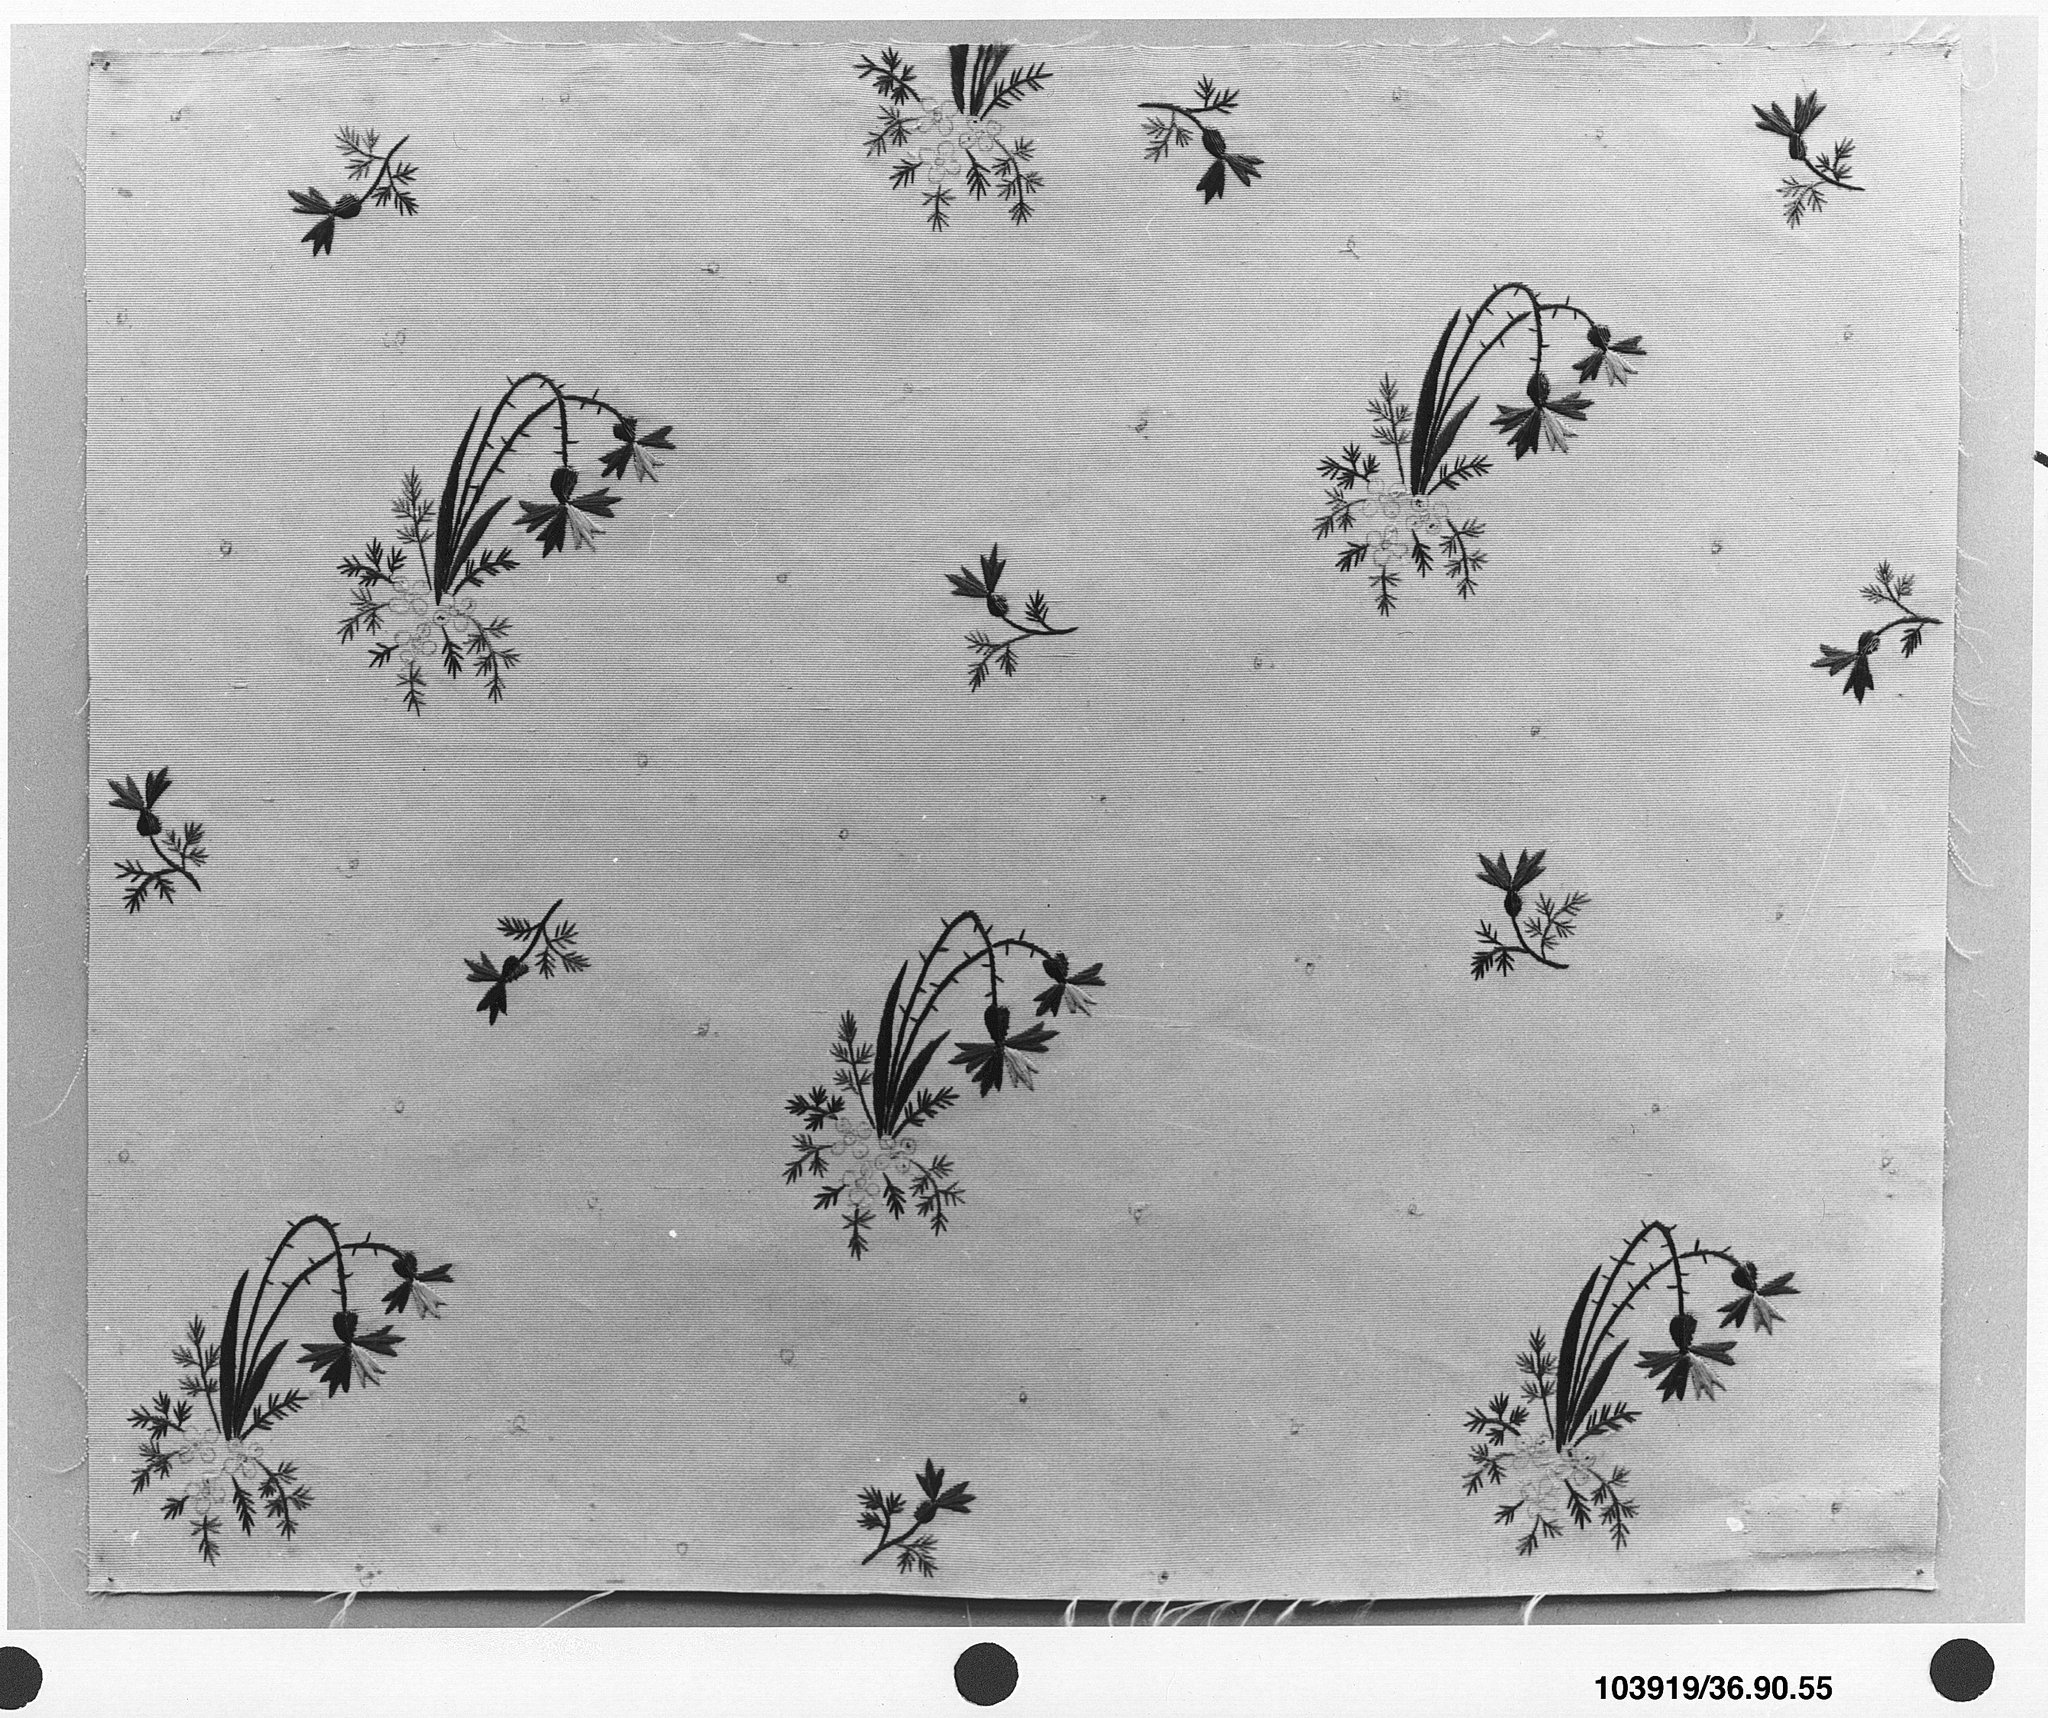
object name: piece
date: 1801-1833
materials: silk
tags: flowers,leaves